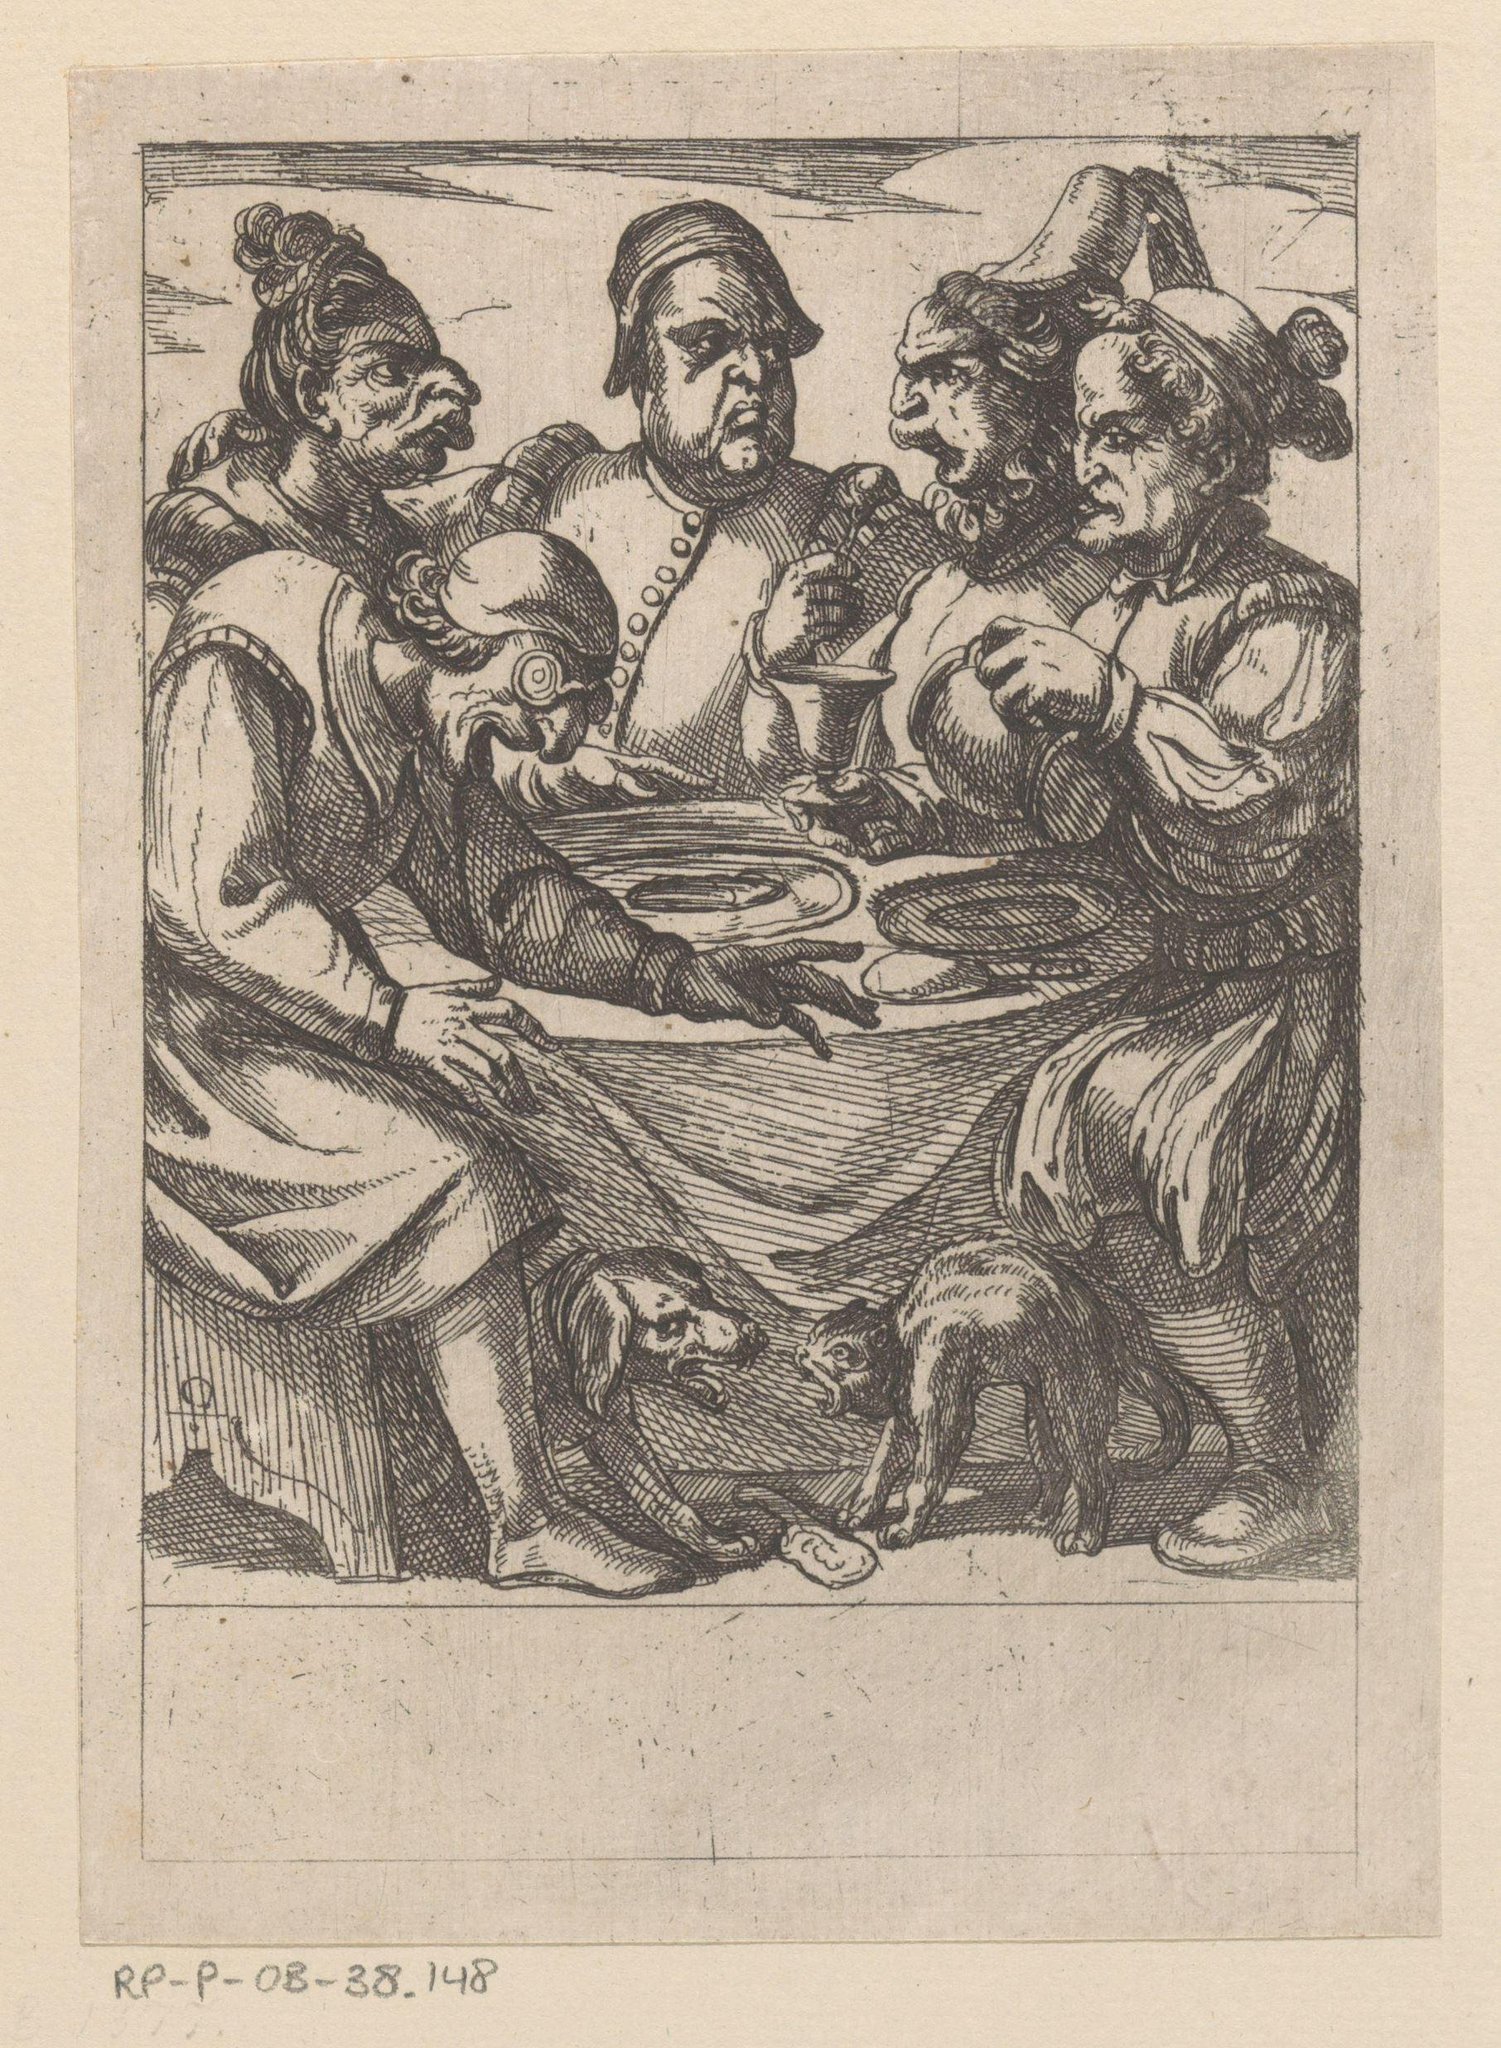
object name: print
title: Groteske figuren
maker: antonio tempesta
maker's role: draughtsman, painter, print maker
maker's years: 1555-1630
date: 1565-1630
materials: paper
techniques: etching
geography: italy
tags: cat, caricatures (human types), (family) meal, dog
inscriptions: collector's mark: Lugt 240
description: Drie groteske mannen en twee lelijke vrouwen zitten rond een tafel en nuttigen een maaltijd. Op de voorgrond een vechtende hond en kat.